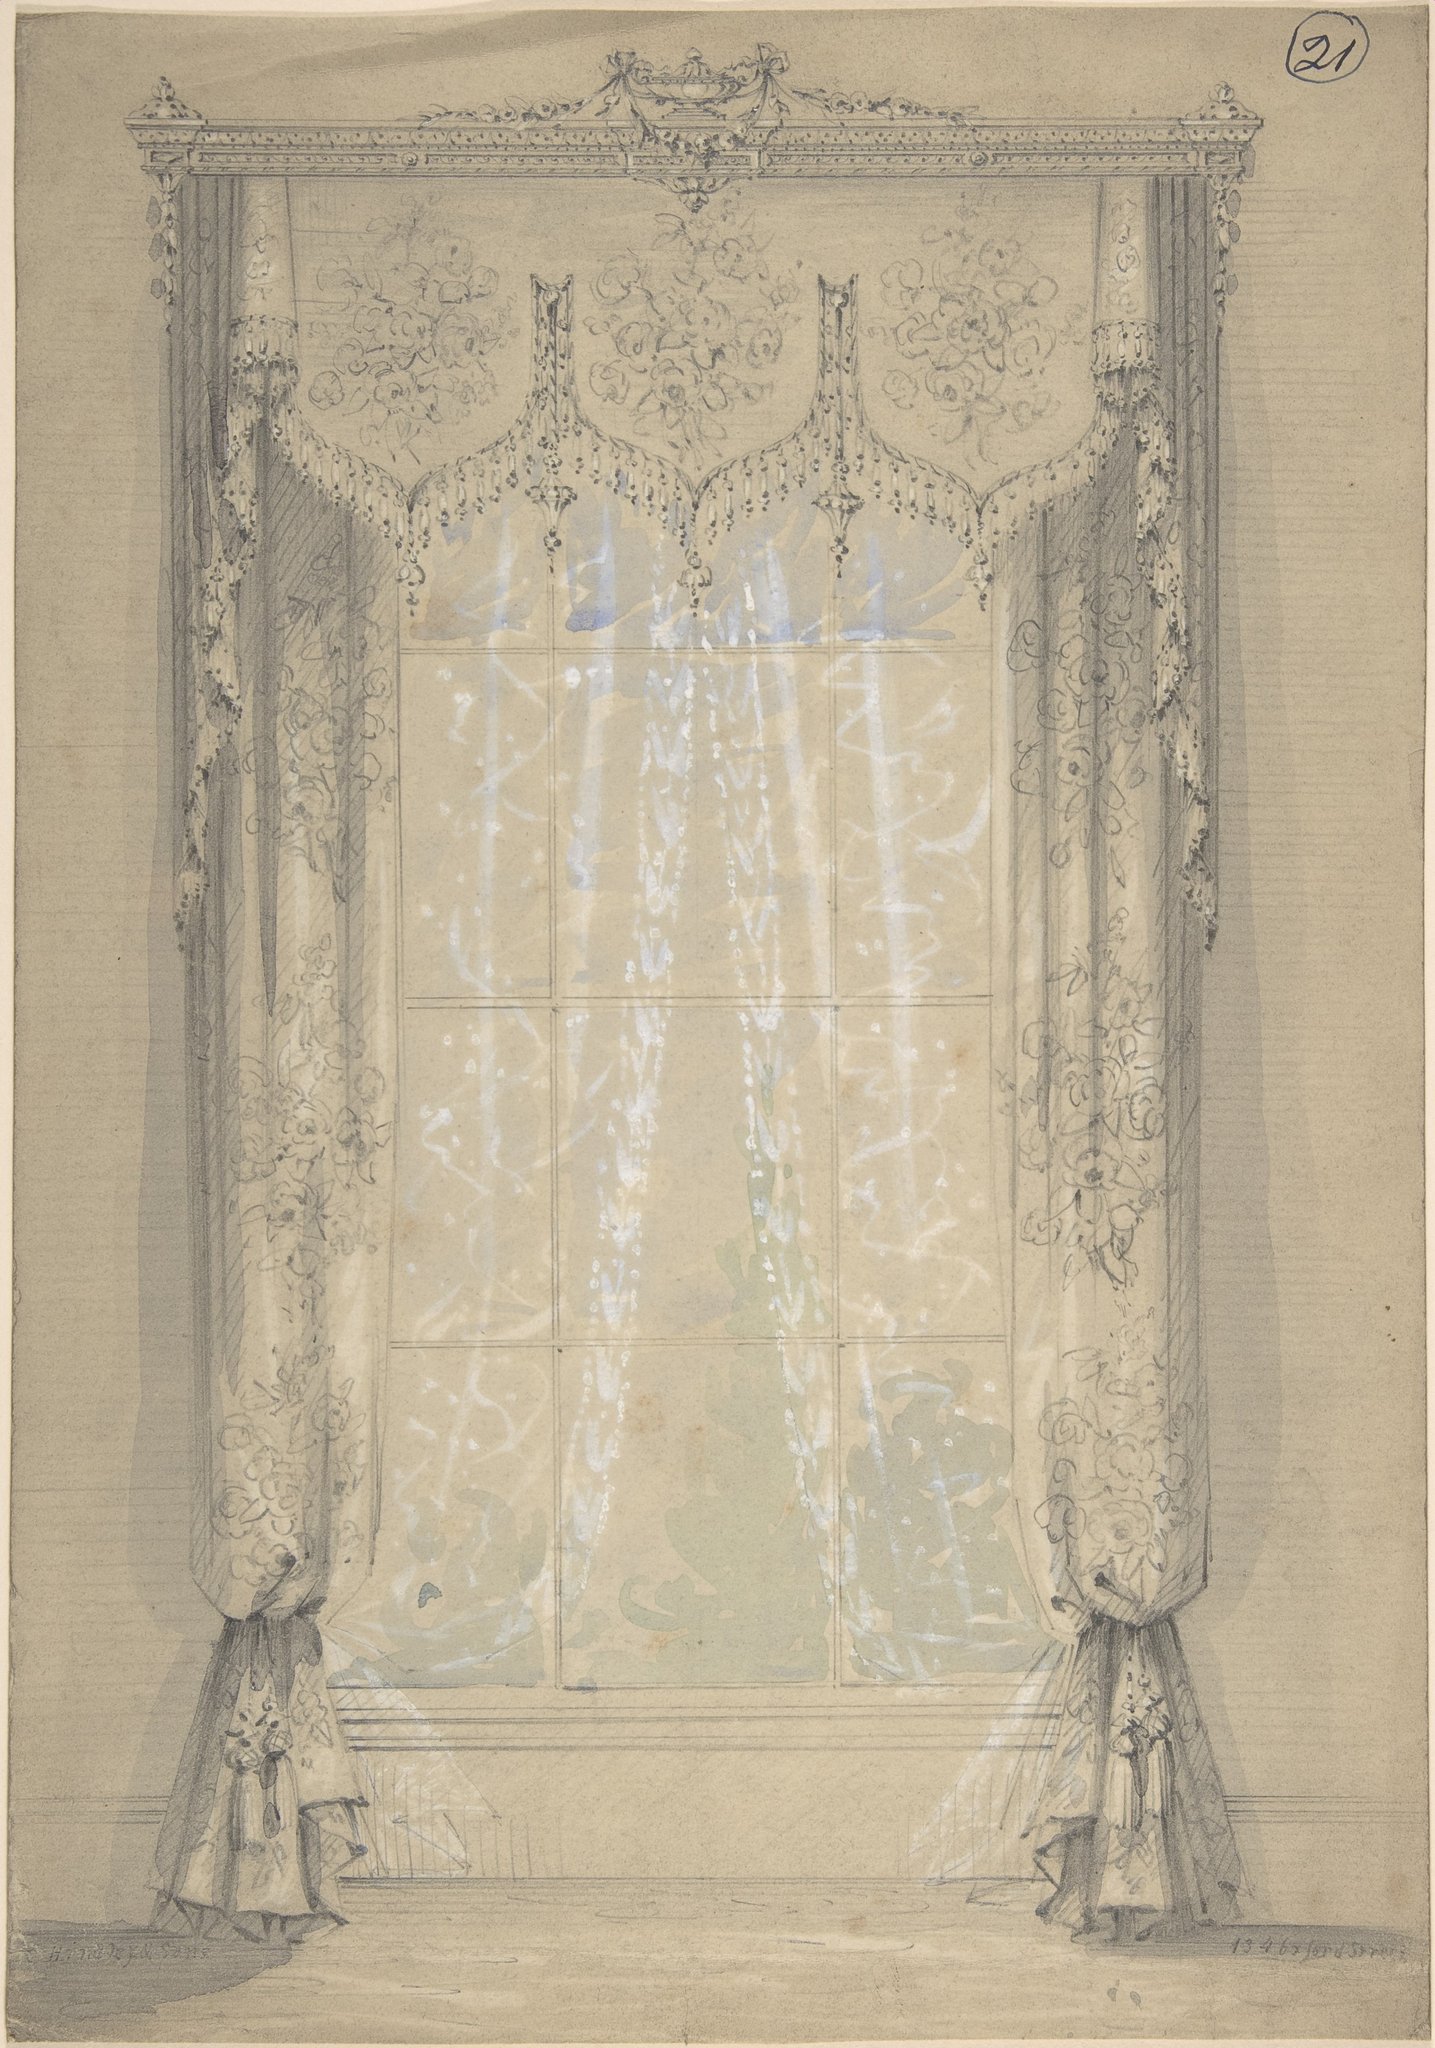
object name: drawing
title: Design for Curtains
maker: charles hindley and sons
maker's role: artist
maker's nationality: british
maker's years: 1841-1917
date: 1841-1917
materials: gouache, graphite, watercolor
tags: windows,curtains